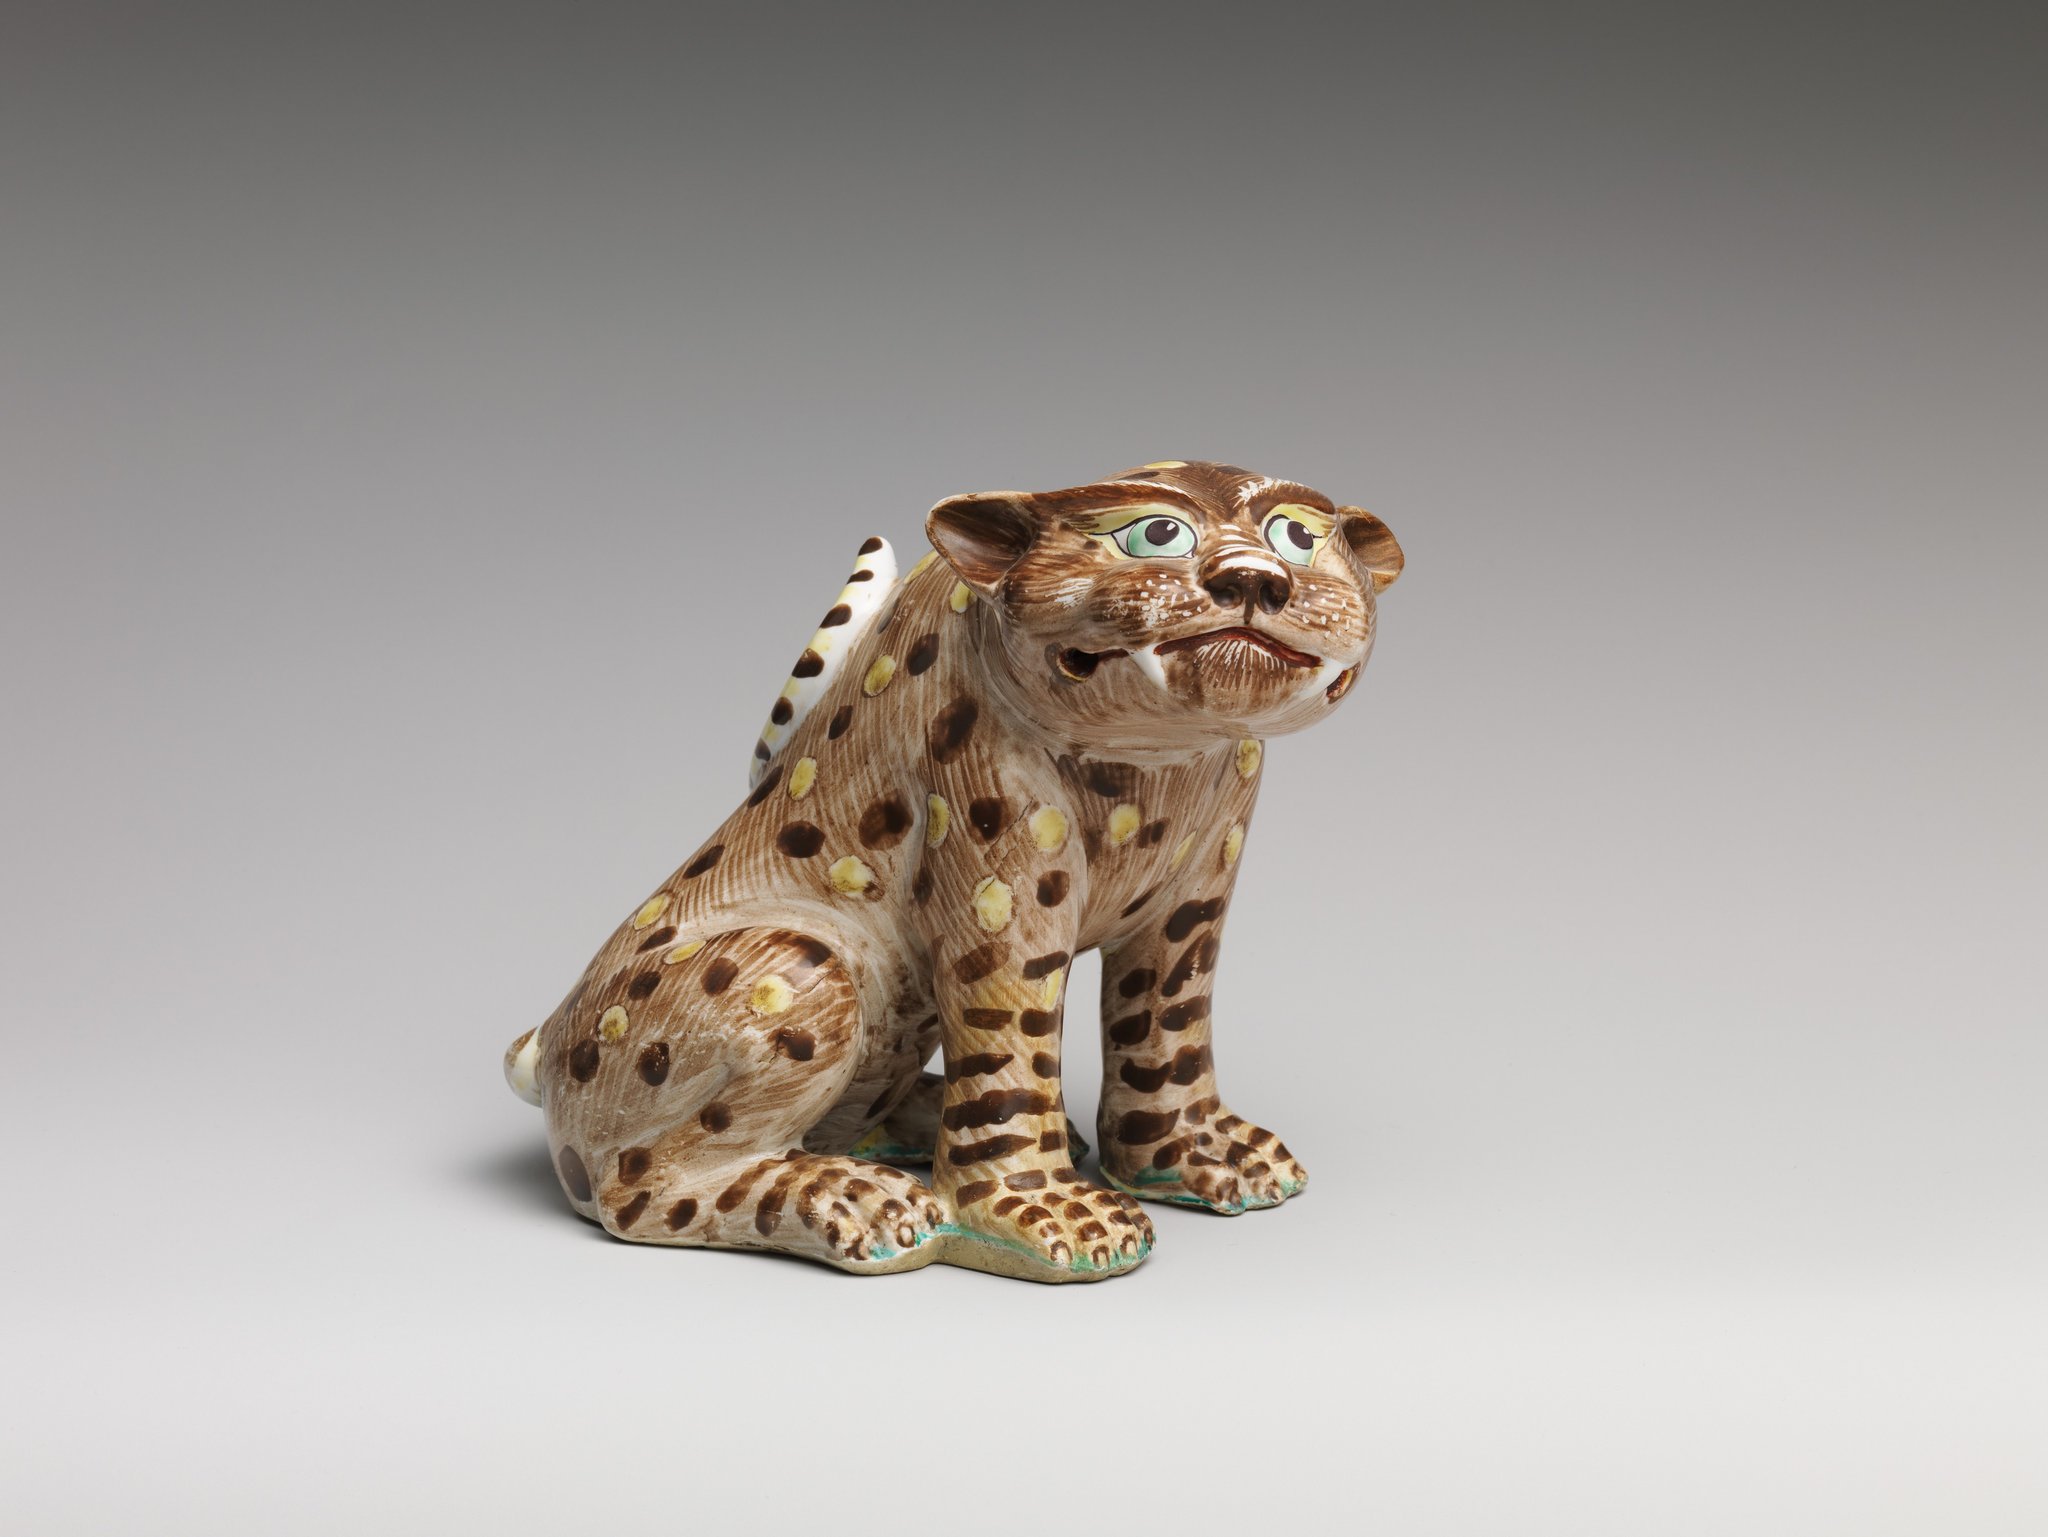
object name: figure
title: Leopard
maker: chantilly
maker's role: factory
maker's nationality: french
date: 1735-1740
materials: soft paste porcelain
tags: leopards